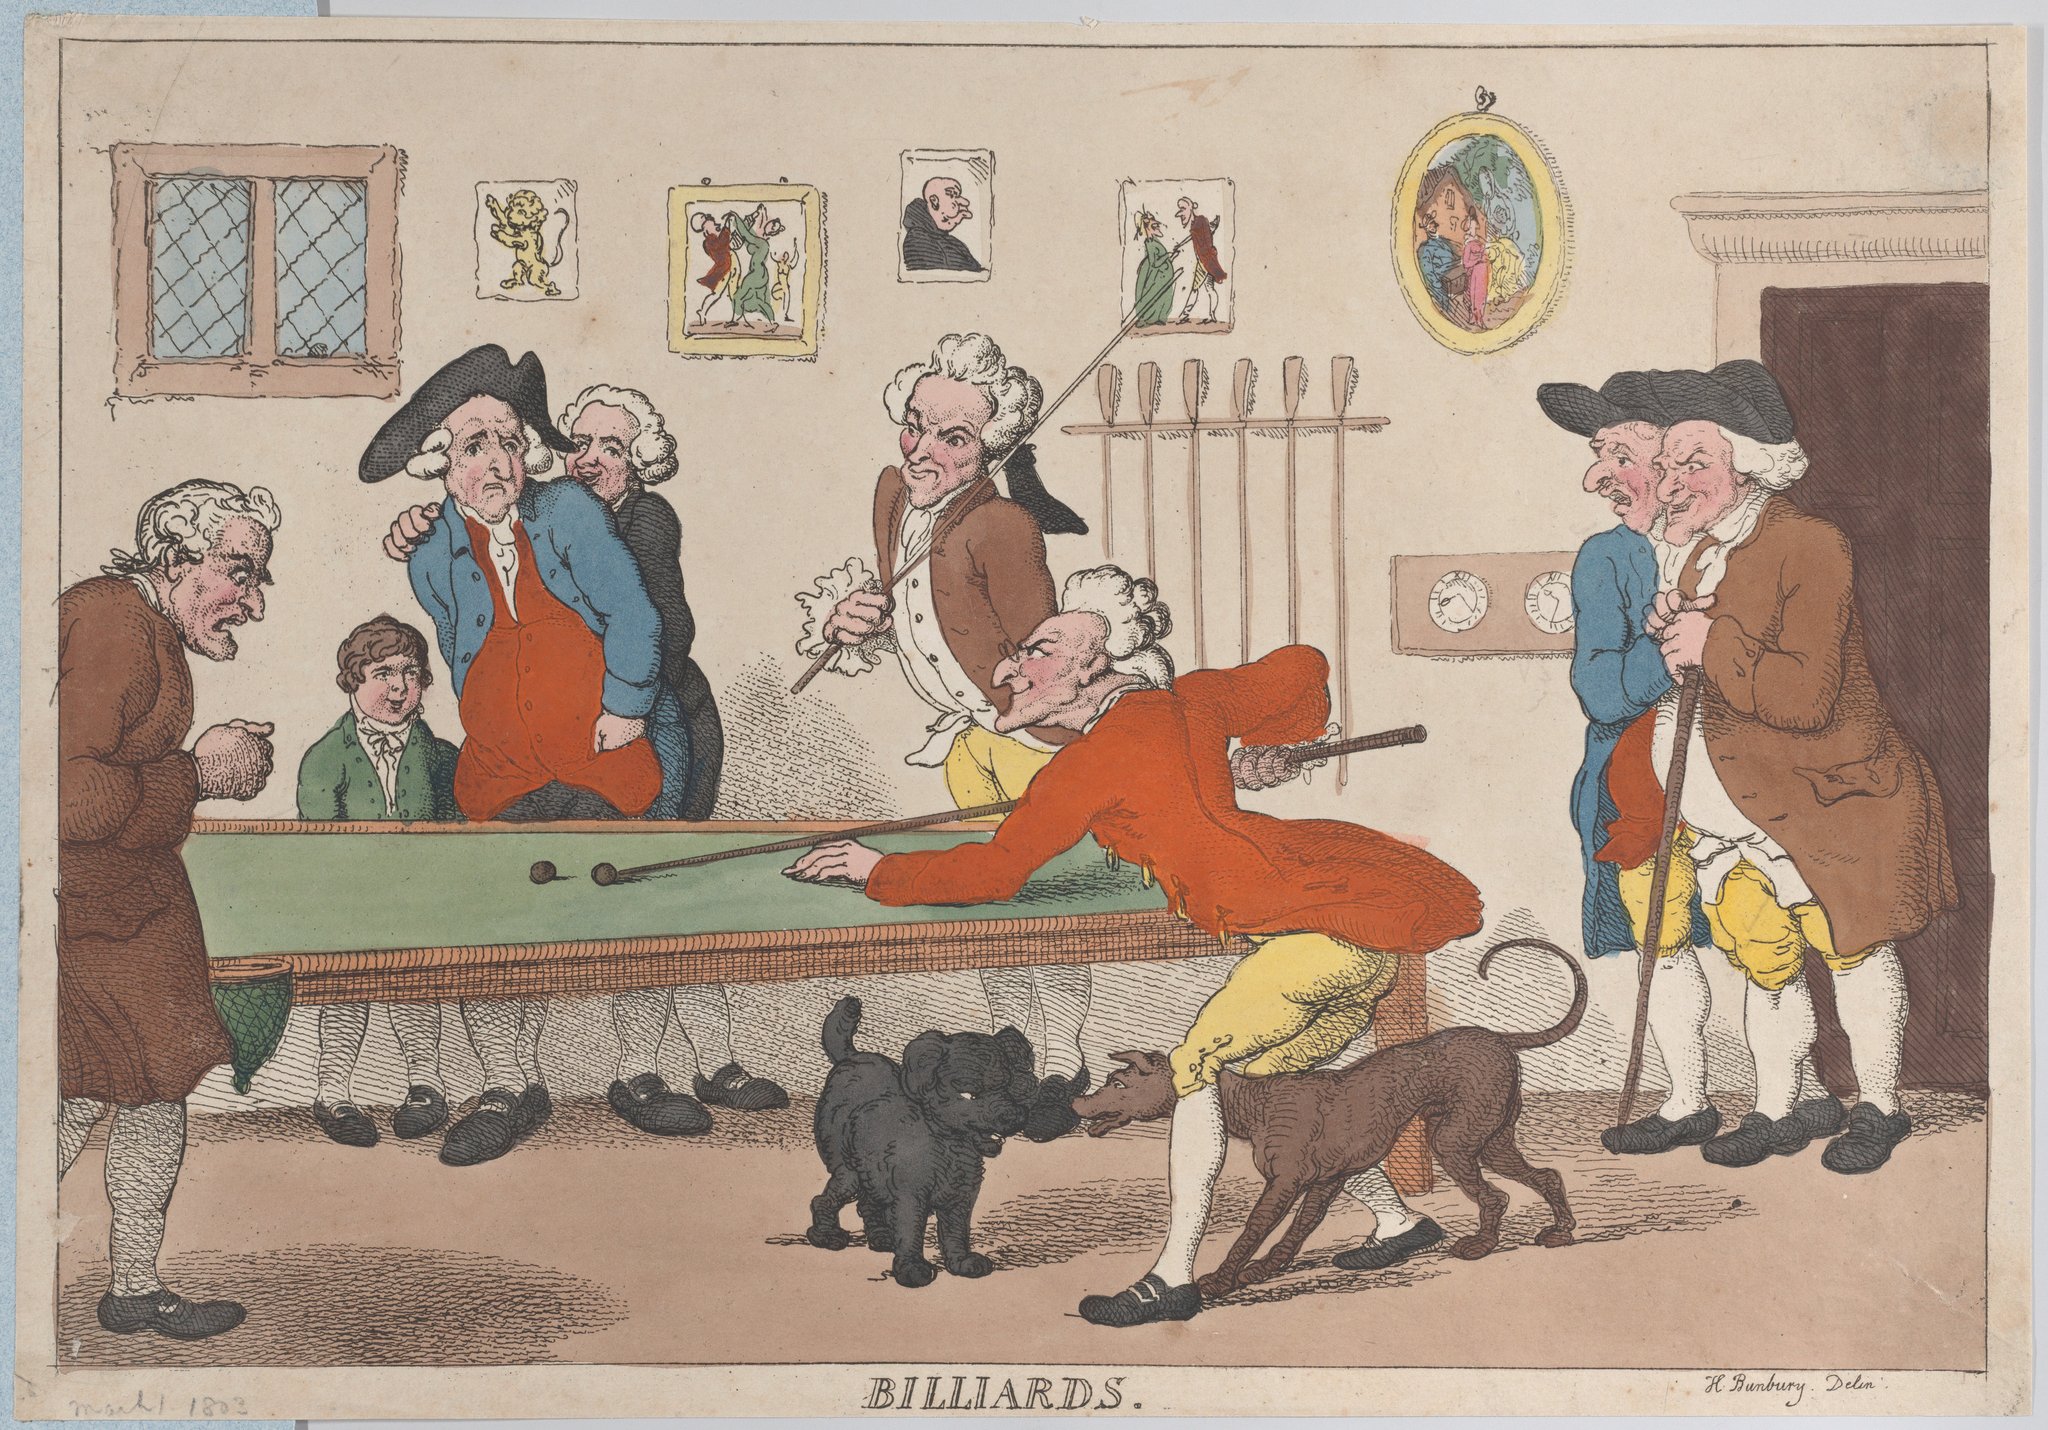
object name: print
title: Billards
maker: thomas rowlandson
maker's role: artist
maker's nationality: british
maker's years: 1757-1827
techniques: etching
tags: satire,men,billiards,dogs